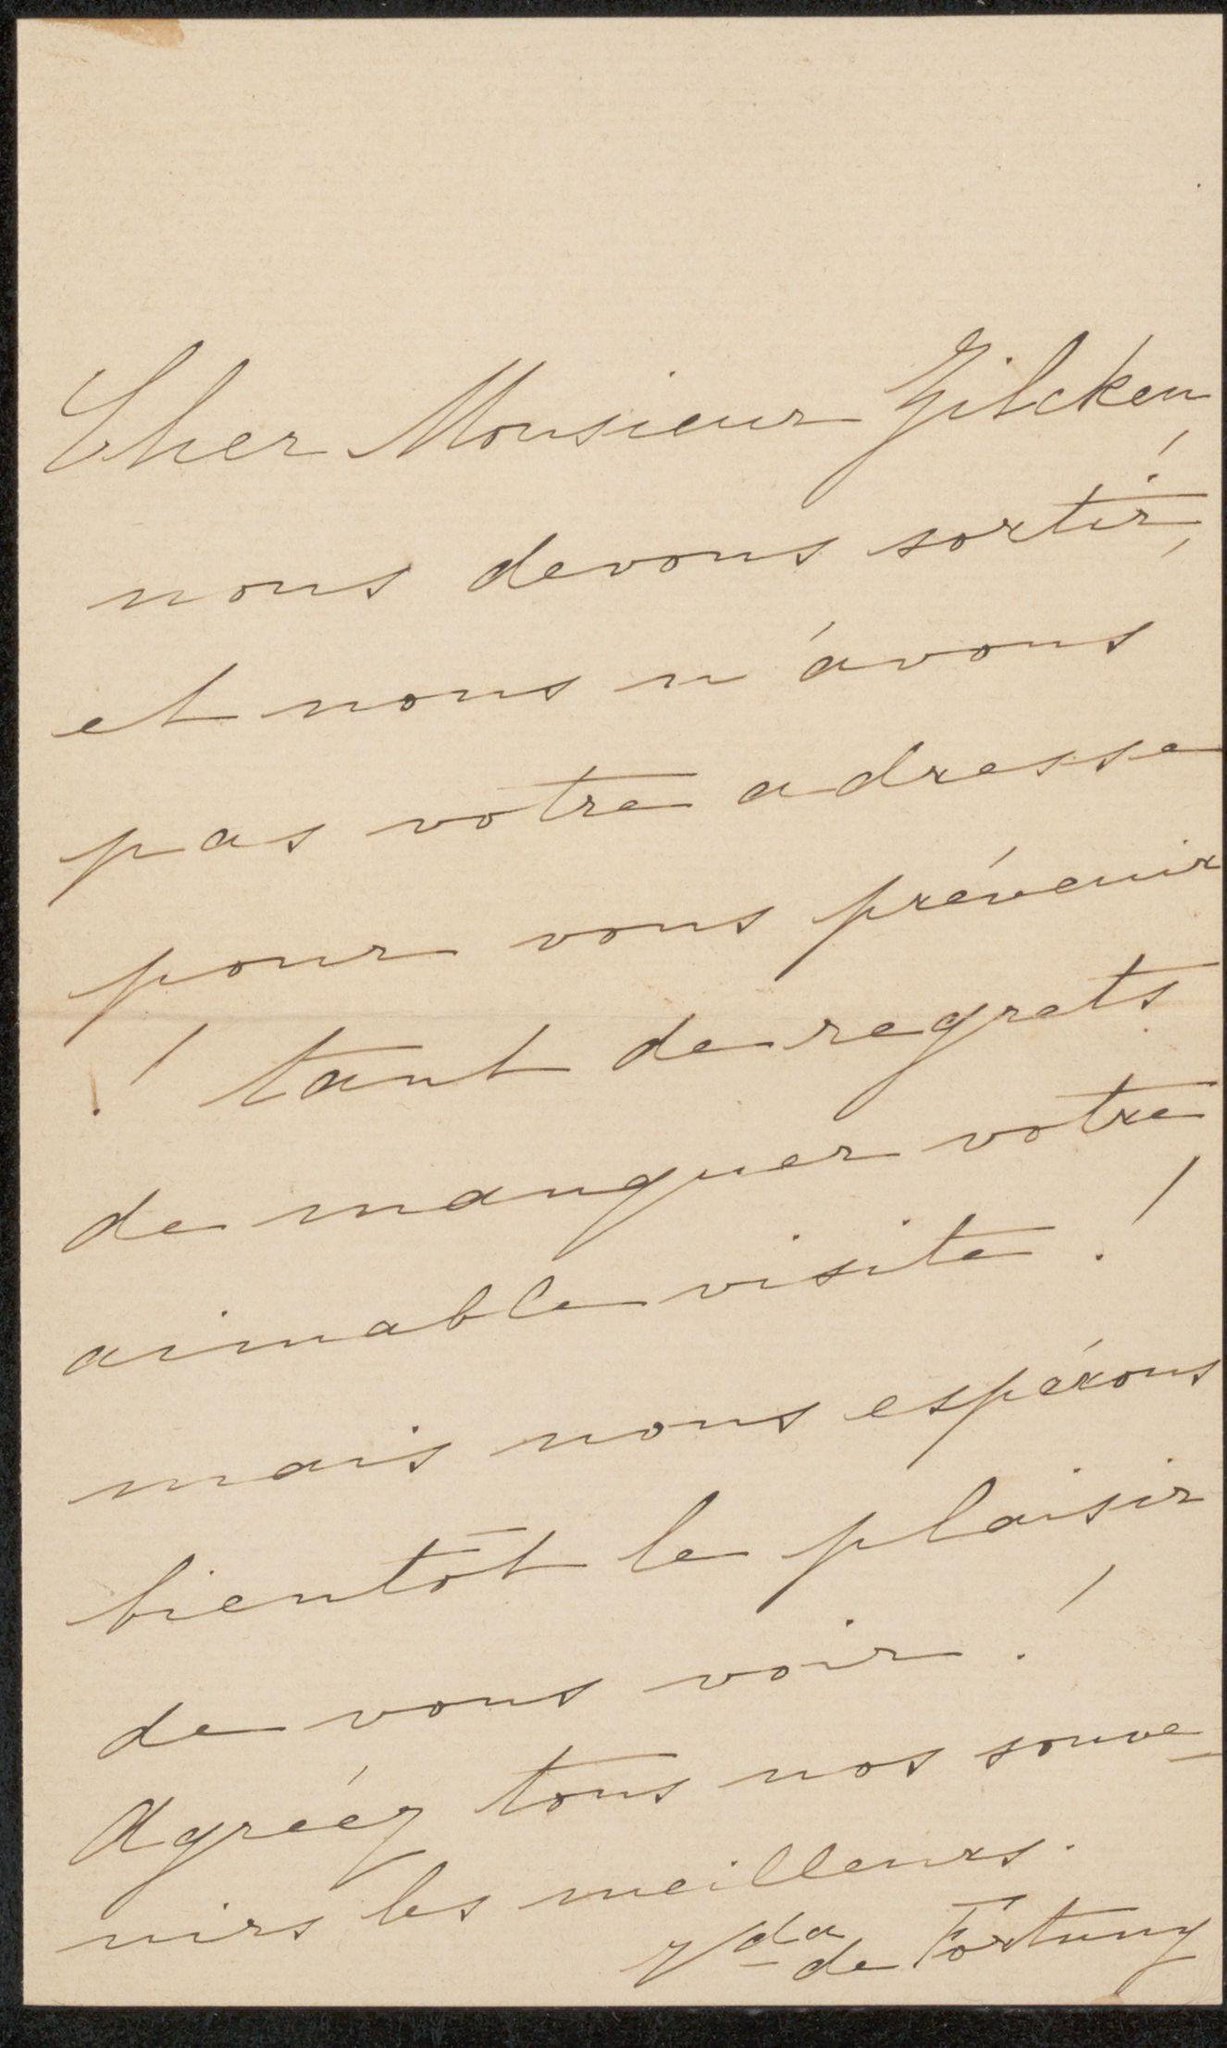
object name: letter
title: Brief aan Philip Zilcken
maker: cecilia de madrazo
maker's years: 1846-1932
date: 1856-1932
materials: ink, paper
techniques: pen, writing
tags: the hague, painter, philip zilcken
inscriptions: collector's mark: ‘RPK’